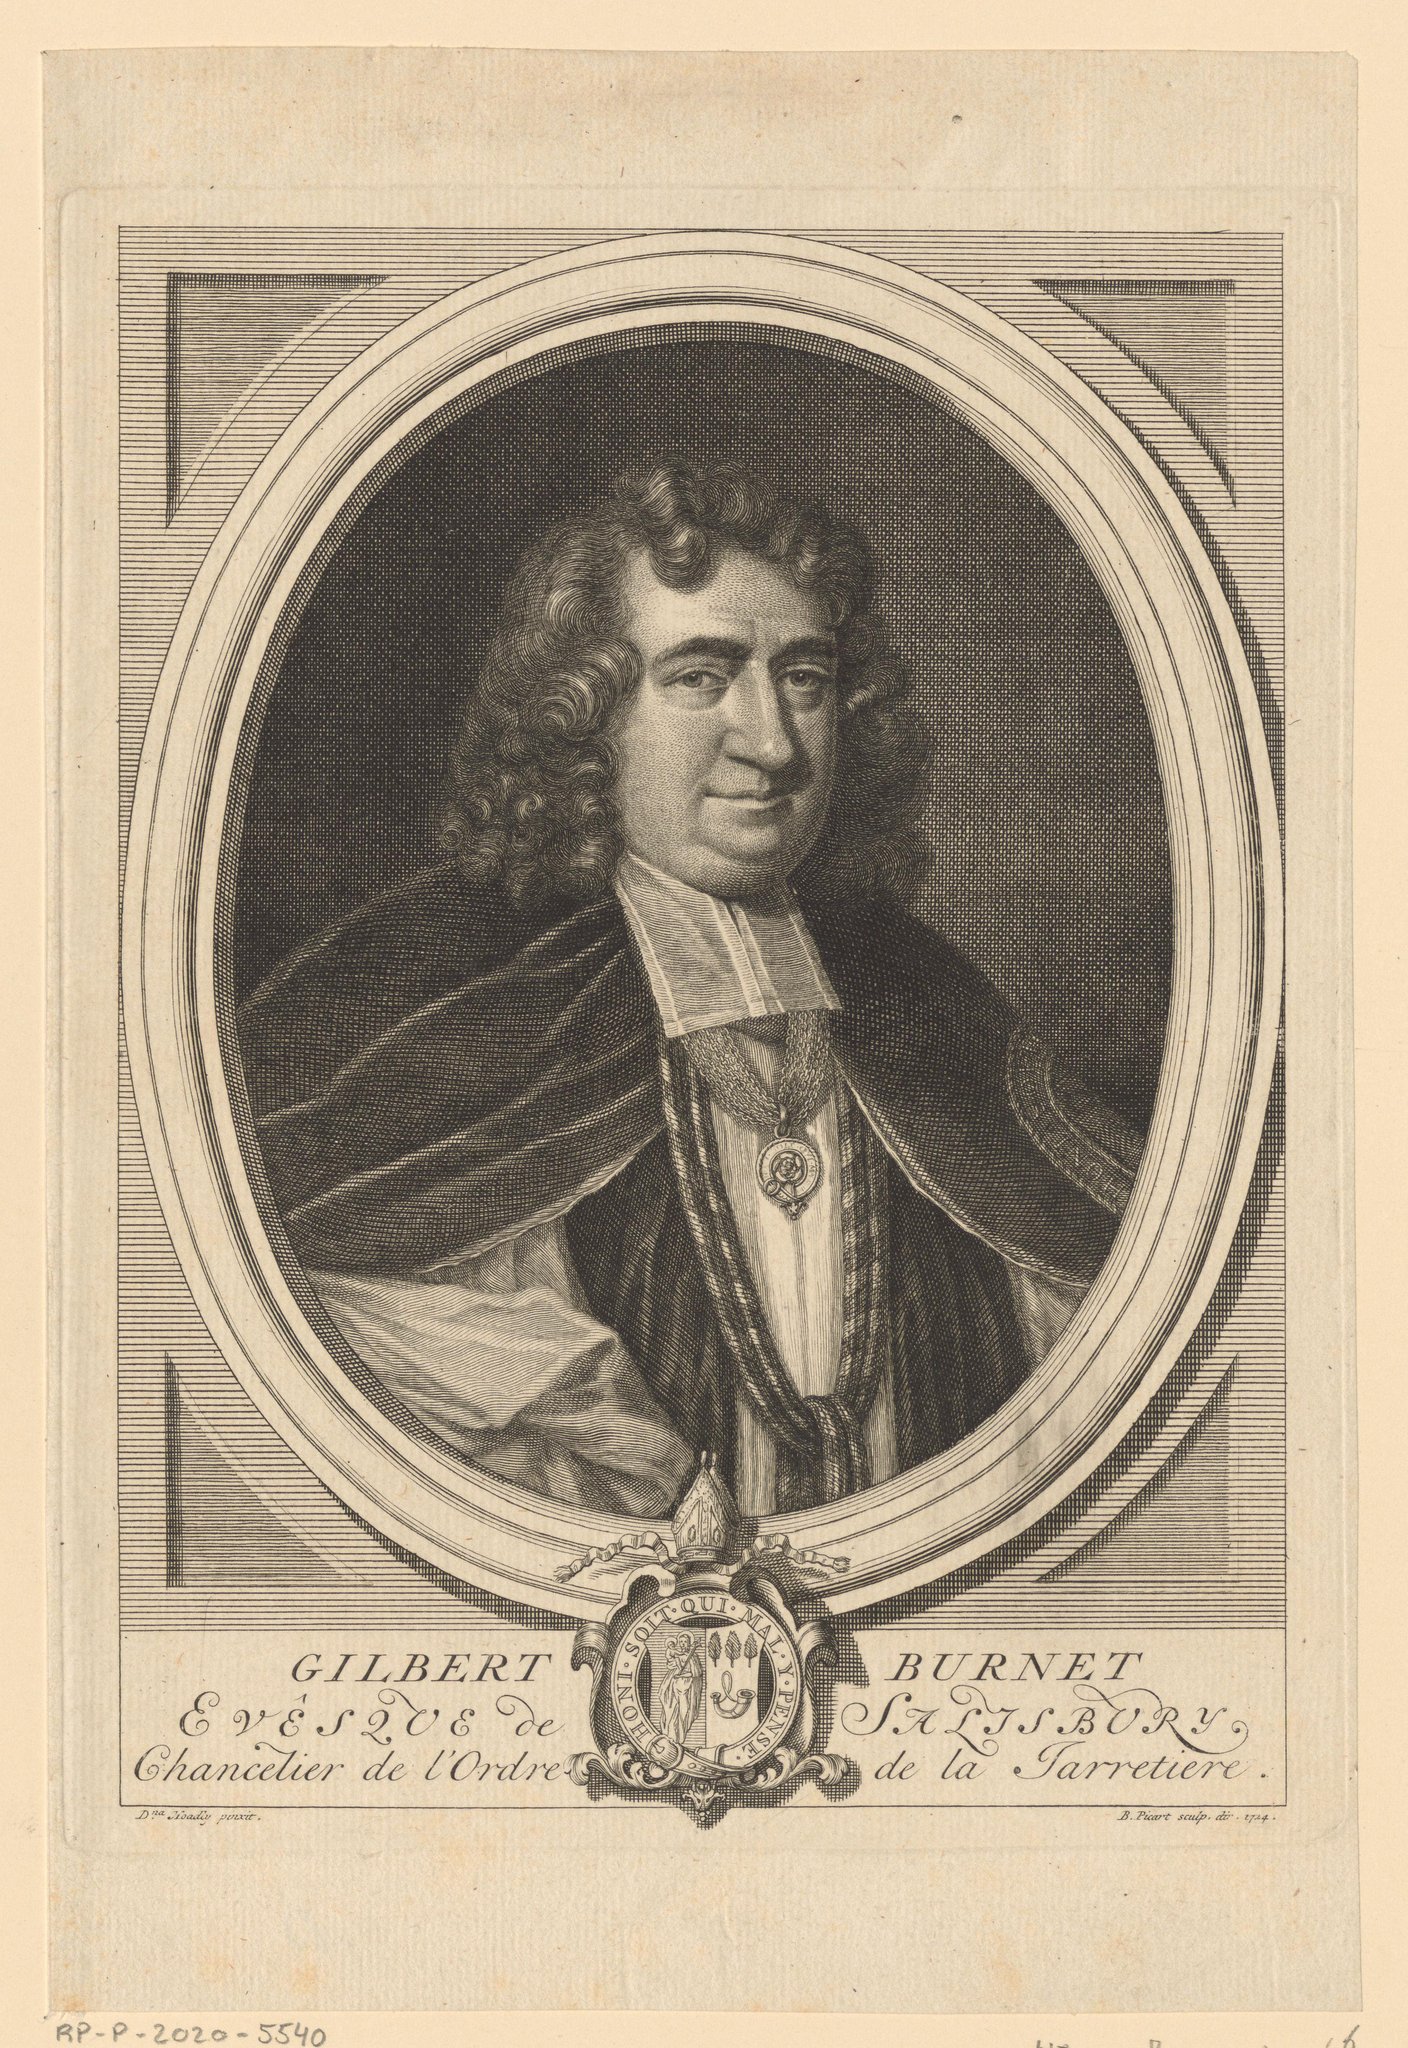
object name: print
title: Portret van Gilbert Burnet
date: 1724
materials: paper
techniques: engraving, etching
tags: clergyman, scholar, philosopher, historical persons, armorial bearing, heraldry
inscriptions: date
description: Prent mogelijk uit: Burnet, Gilbert. Histoire des dernières révolutions d'Angleterre. Den Haag: Jean Neaulme, 1725.